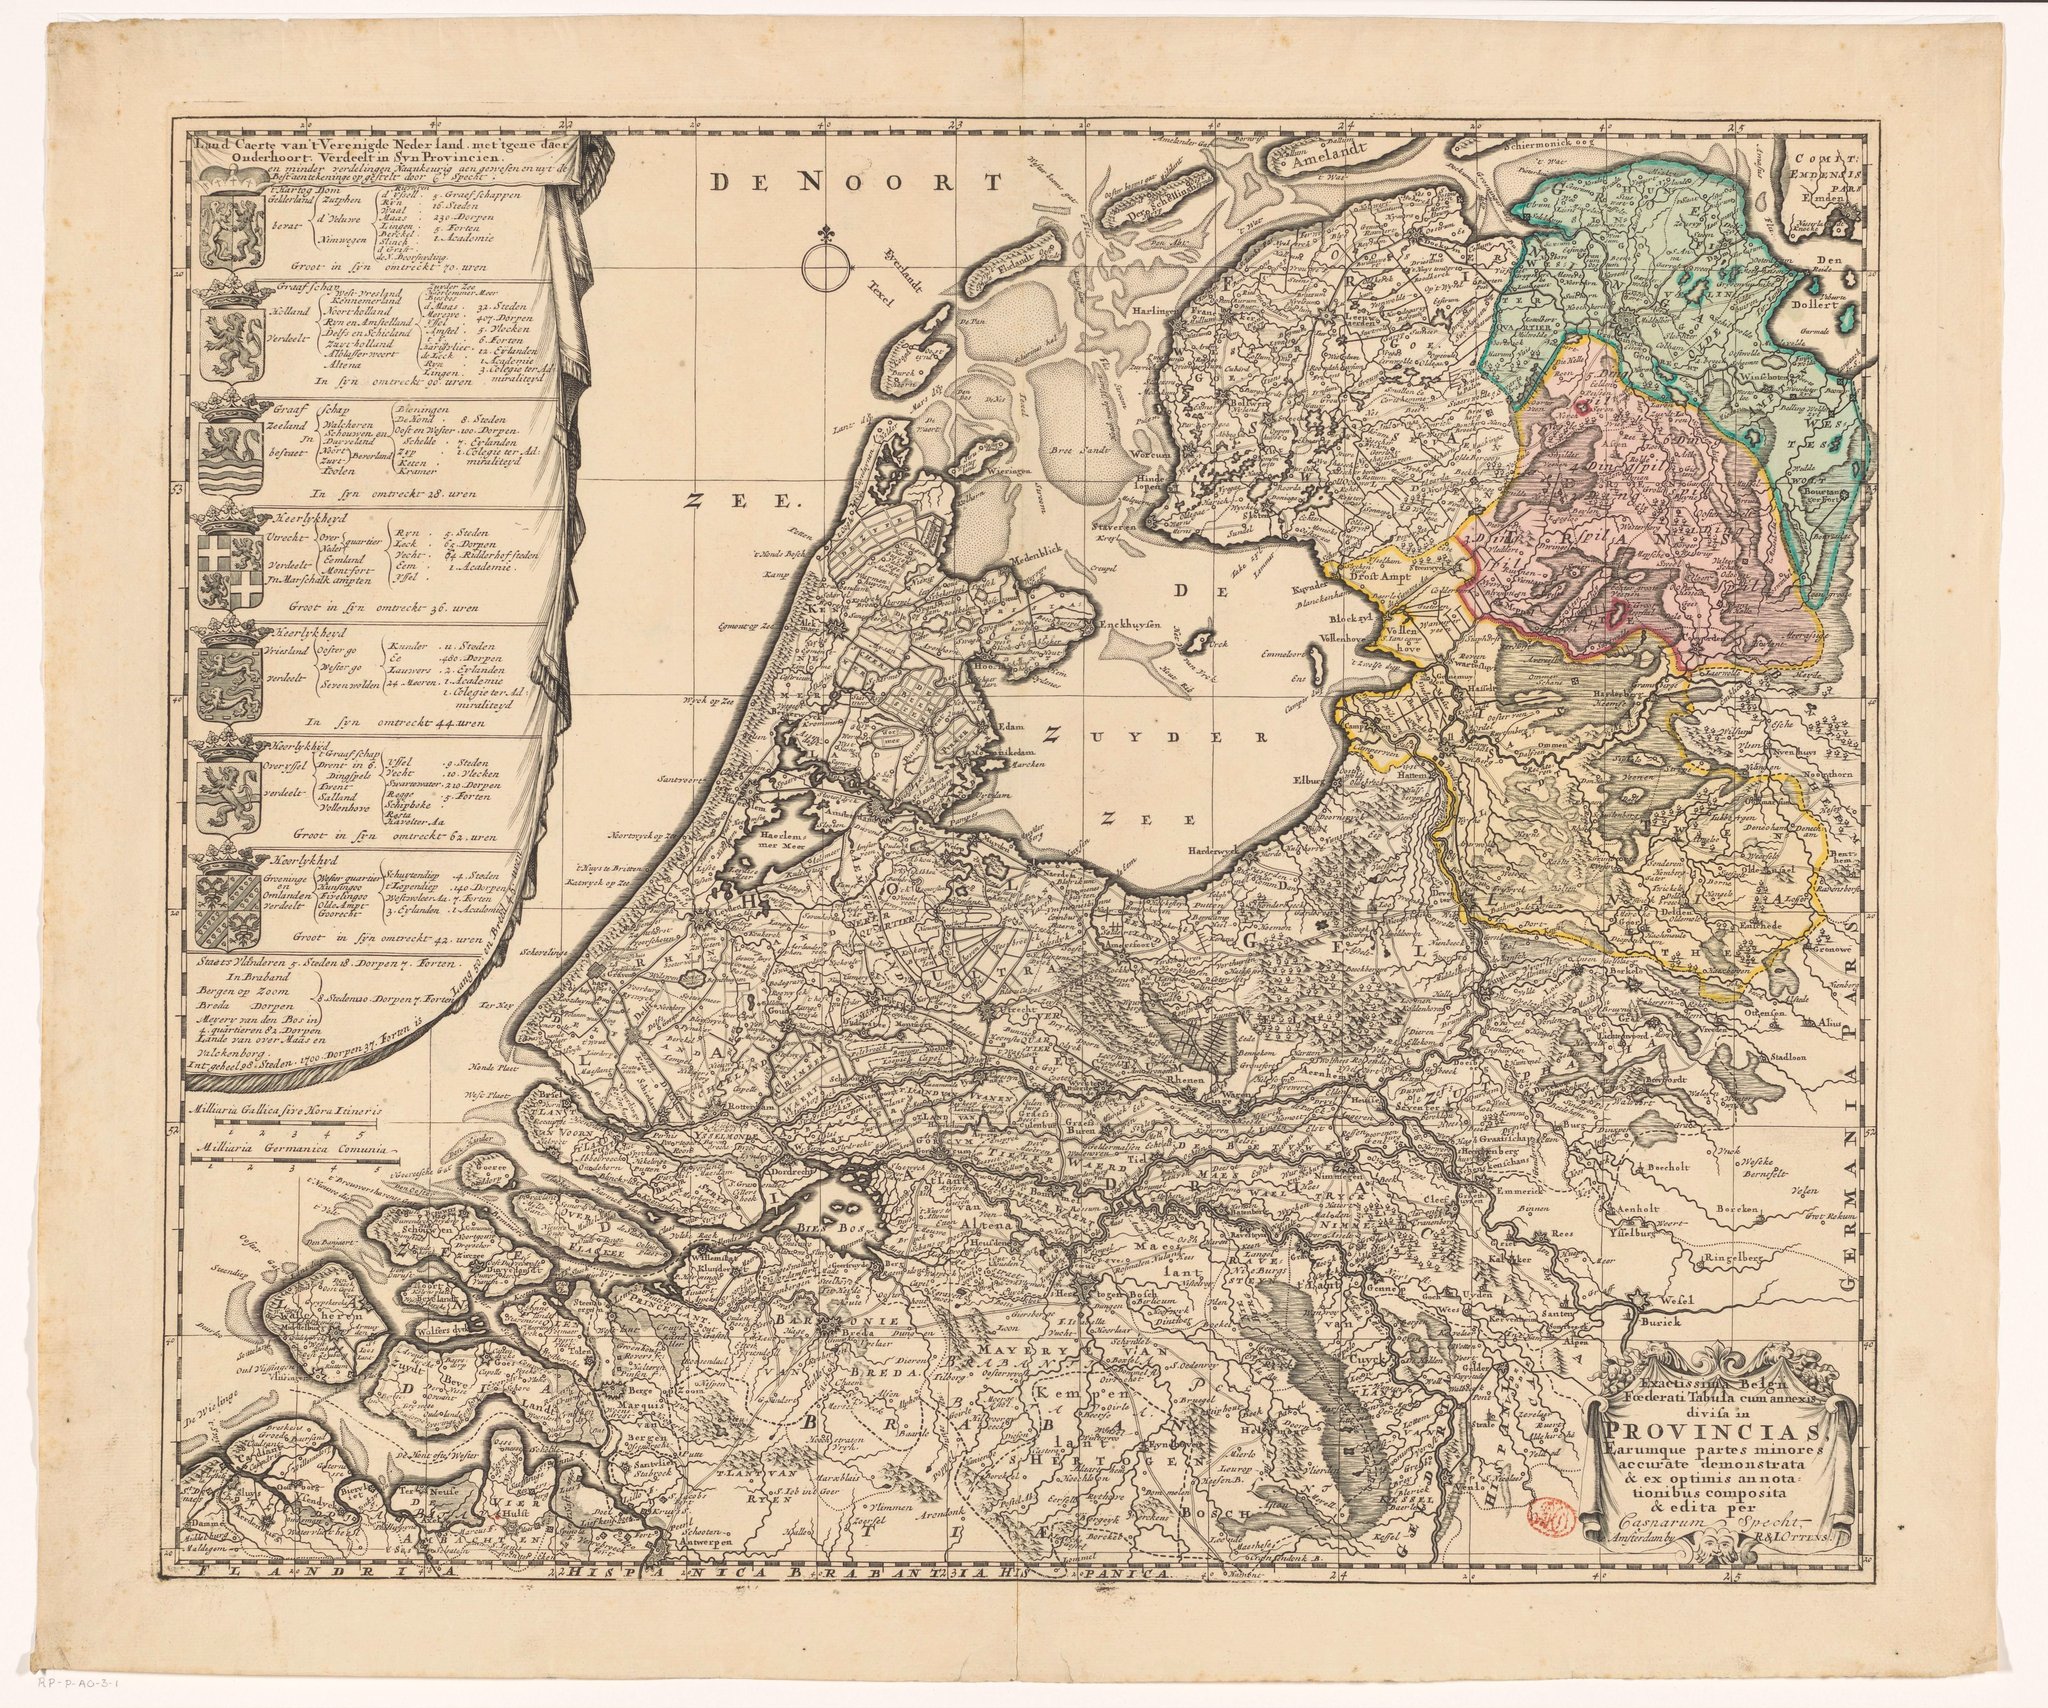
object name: map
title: Land caerte van 't Verenigde Nederland met 't gene daer onderhoort verdeelt in syn Provincien (...) / Exactissima Belgii Foederati tabula cum annexis divisa in provincias (...)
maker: caspar specht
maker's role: print maker, publisher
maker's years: 1654-1710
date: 1702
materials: paper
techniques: engraving, hand coloring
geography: amsterdam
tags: maps of separate countries or regions, coat of arms (as symbol of the state, etc.) (+ province; provincial), netherlands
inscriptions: collector's mark: Lugt 195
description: Links een langwerpige cartouche met daarin de Nederlandse titel en de wapens van en topografische en staatkundige informatie over de Zeven Provinciën. Daaronder twee schaalstokken: Milliaria Gallica sive hora itineris, Milliaria Germanica comunia. Rechtsonder een cartouche met de Latijnse titel. De kaart is voorzien van een coördinaten-net en een gradenverdeling langs randen.